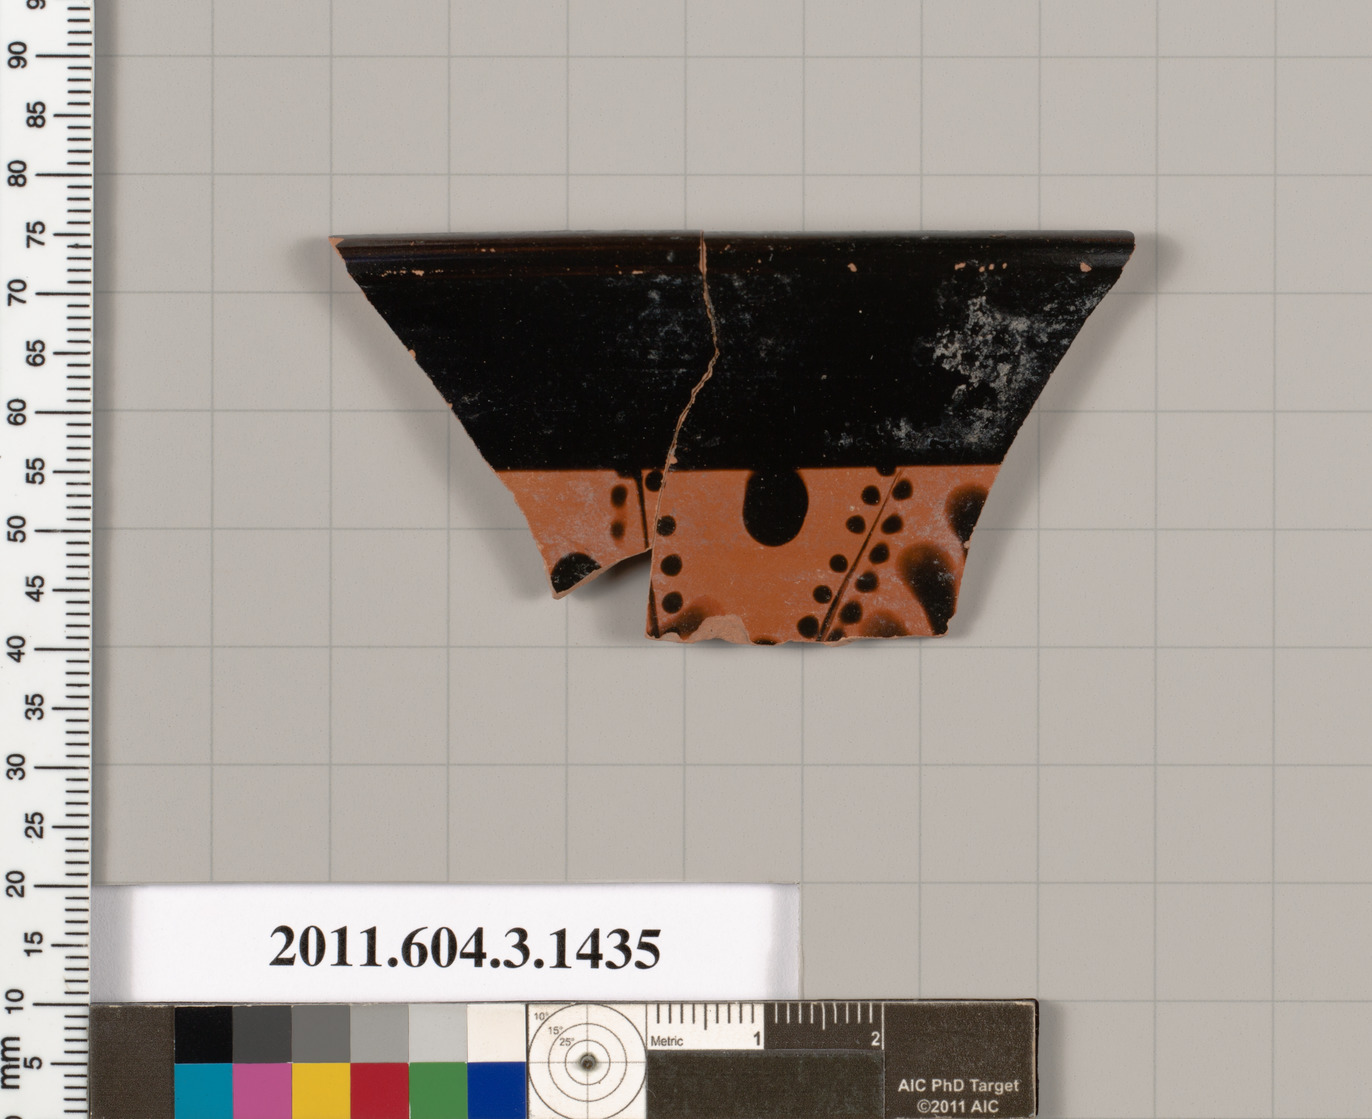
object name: skyphos fragment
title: Terracotta rim fragment of a skyphos (deep drinking cup)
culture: greek, attic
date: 534-468 BCE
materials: terracotta